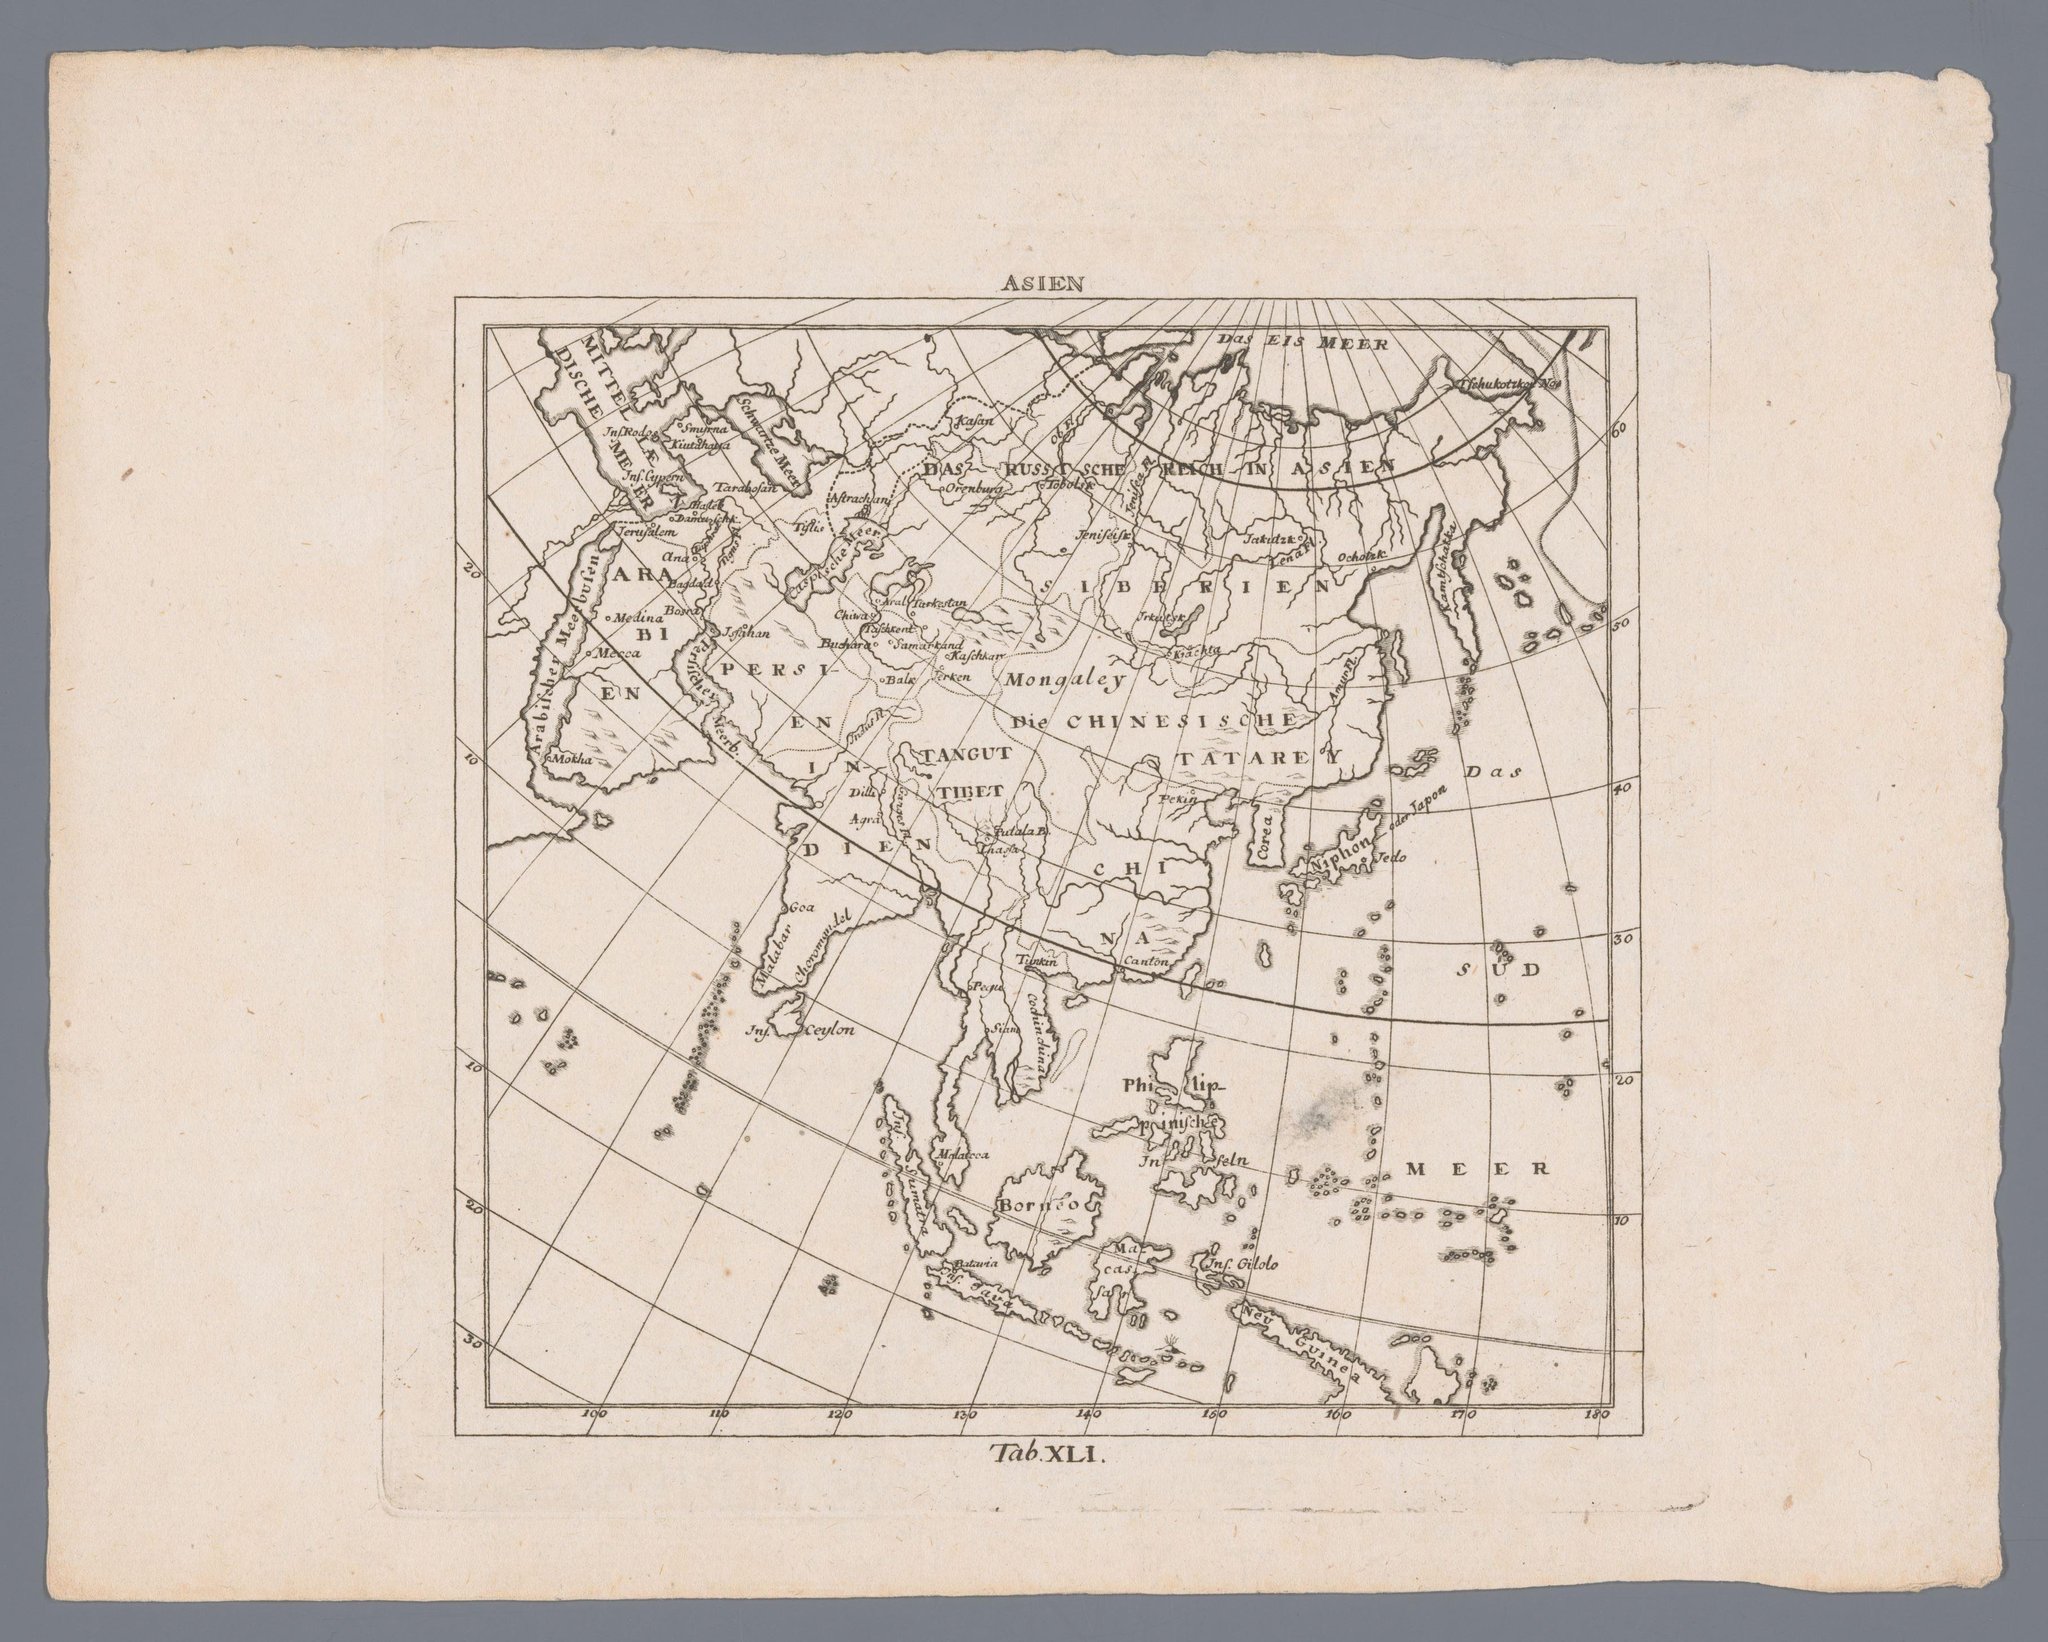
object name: print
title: Elementarische Landkarte von Asien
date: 1774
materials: paper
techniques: etching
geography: germany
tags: (map of) asia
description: Prent ook gebruikt in: Basedow, Johann Bernhard. Das Basedowische Elementarwerk. Ein Vorrath der besten Erkenntnisse zum Lernen, Lehren, Wiederholen und Nachdenken. Leipzig: Siegfried Lebrecht Crucius, 1774.